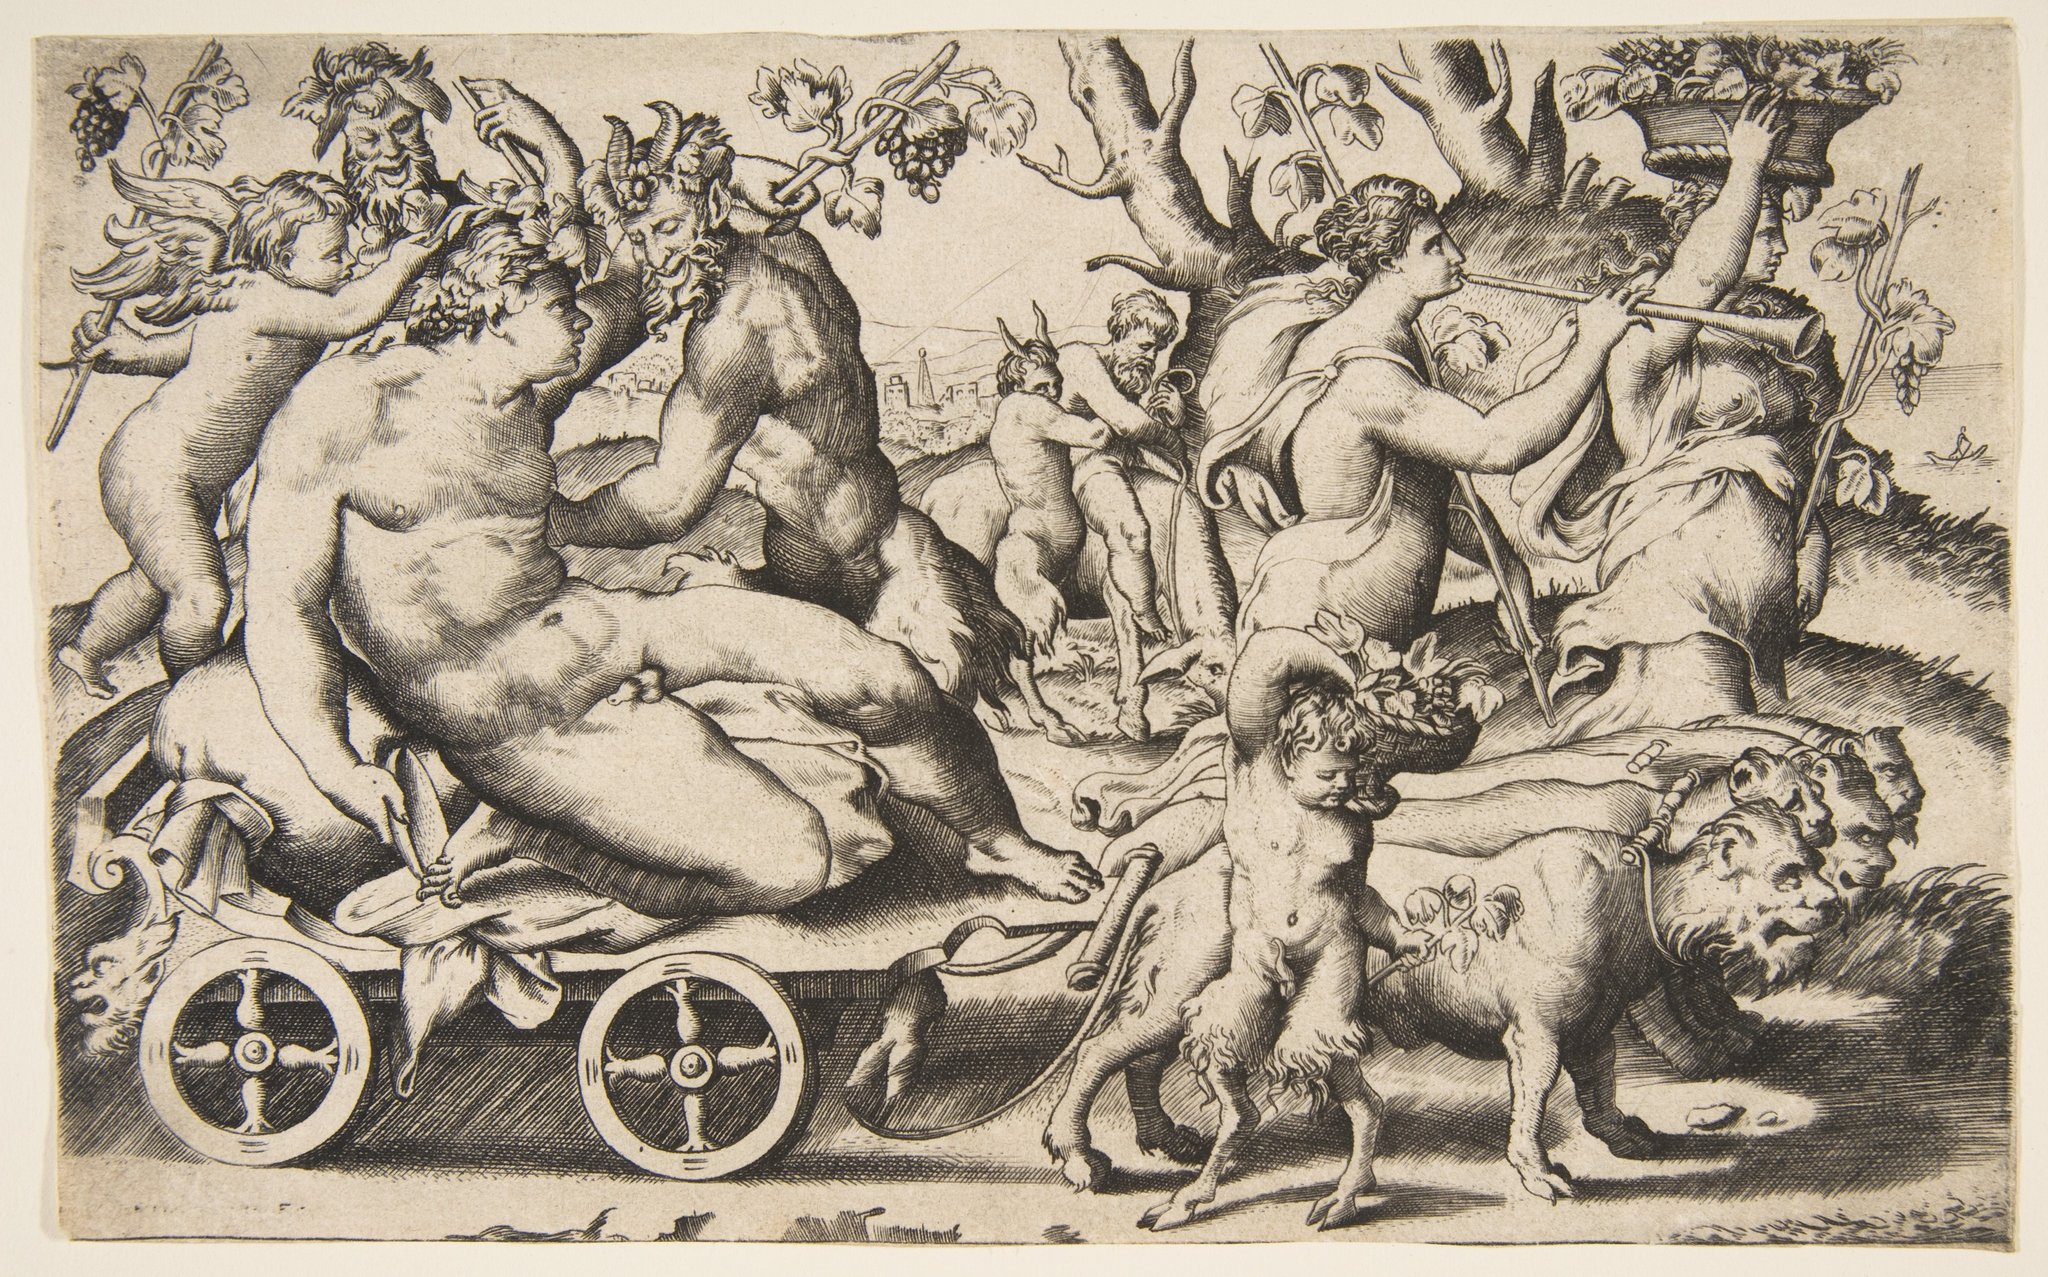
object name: print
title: Triumph of Bacchus who is seated on a carriage at left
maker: giulio bonasone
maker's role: artist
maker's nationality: italian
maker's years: 1510-1576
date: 1531-1576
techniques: engraving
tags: musical instruments,bacchus,satyrs,lions